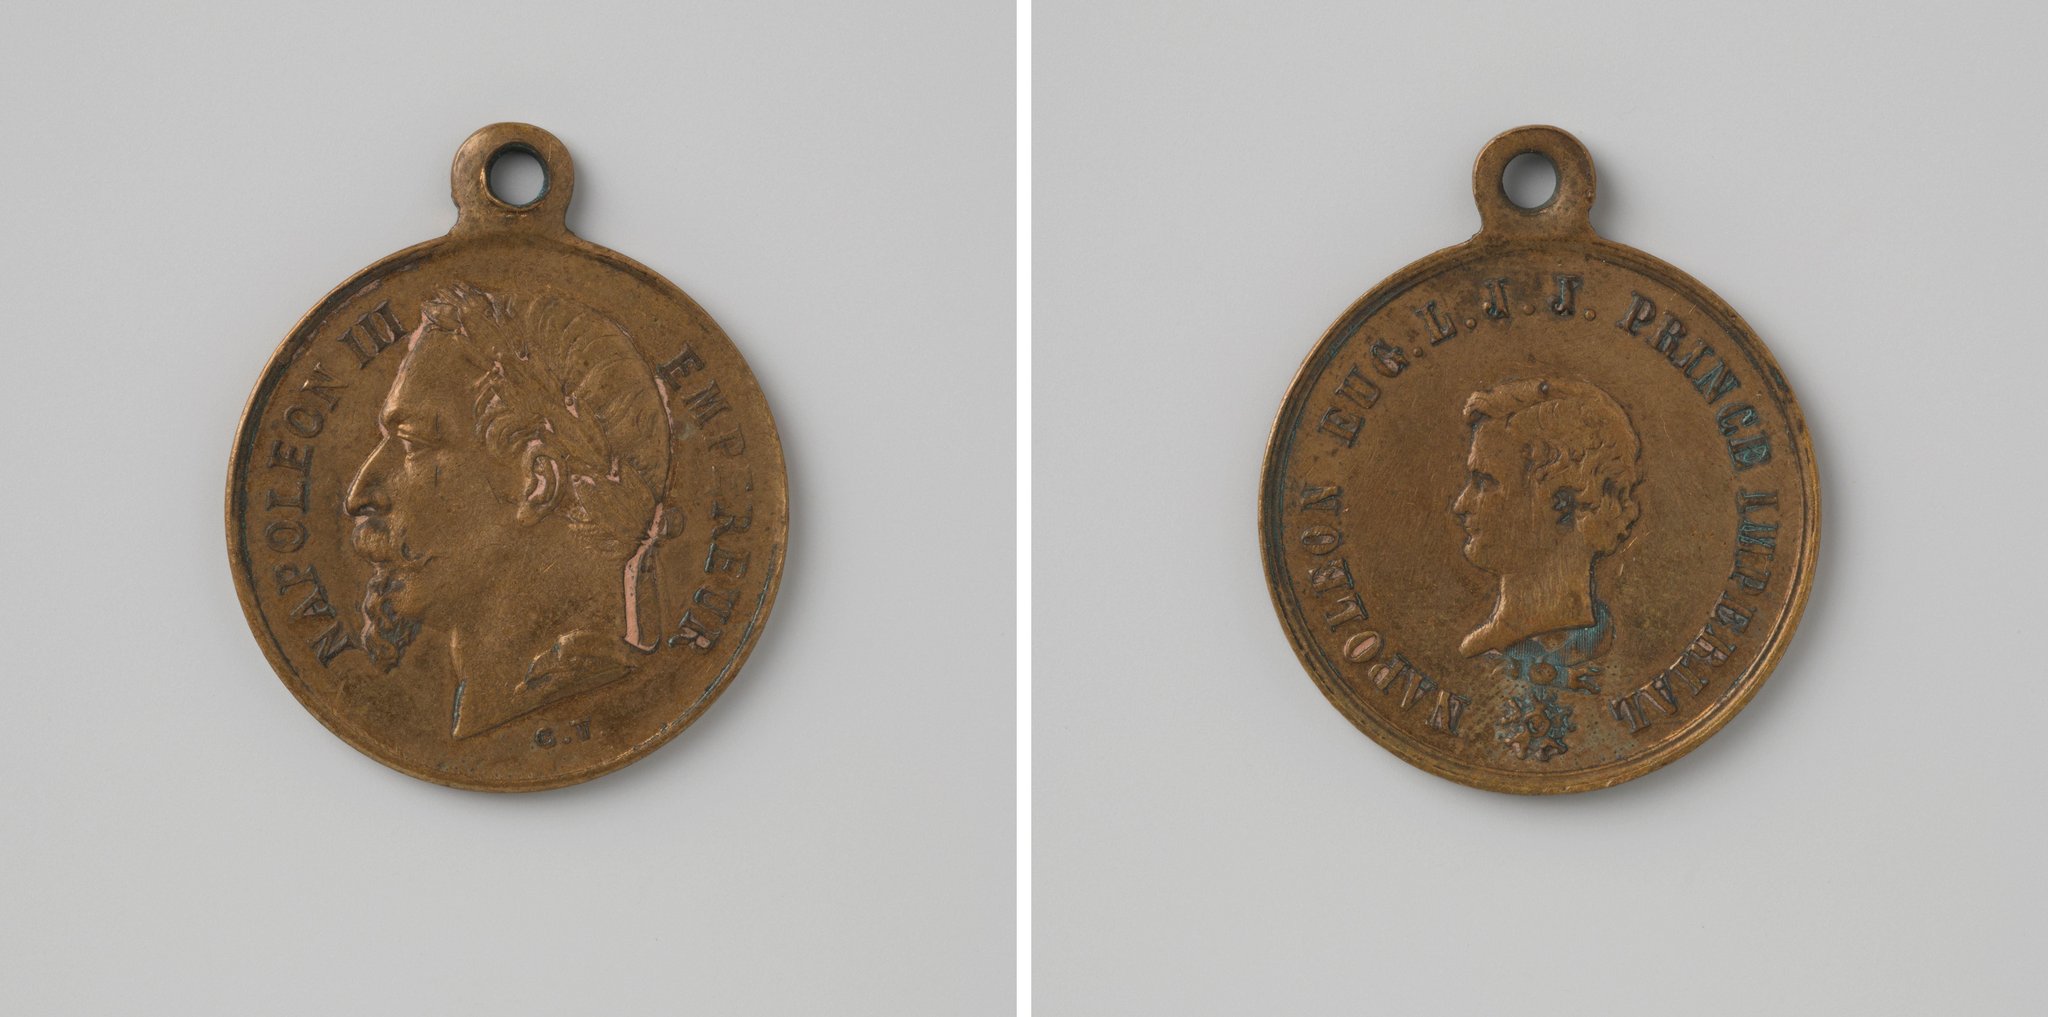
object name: history medal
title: Napoleon Eugène Louis Jean Joseph Bonaparte keizerlijk prins van Frankrijk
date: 1860-1870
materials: brass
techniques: striking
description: Messing penning met draagoog, op de voorzijde het portret van Keizer Napoleon III naar links met omschrift, op de keerzijde het portret van Prins Napoleon naar links boven een ridderorde, met omschrift.